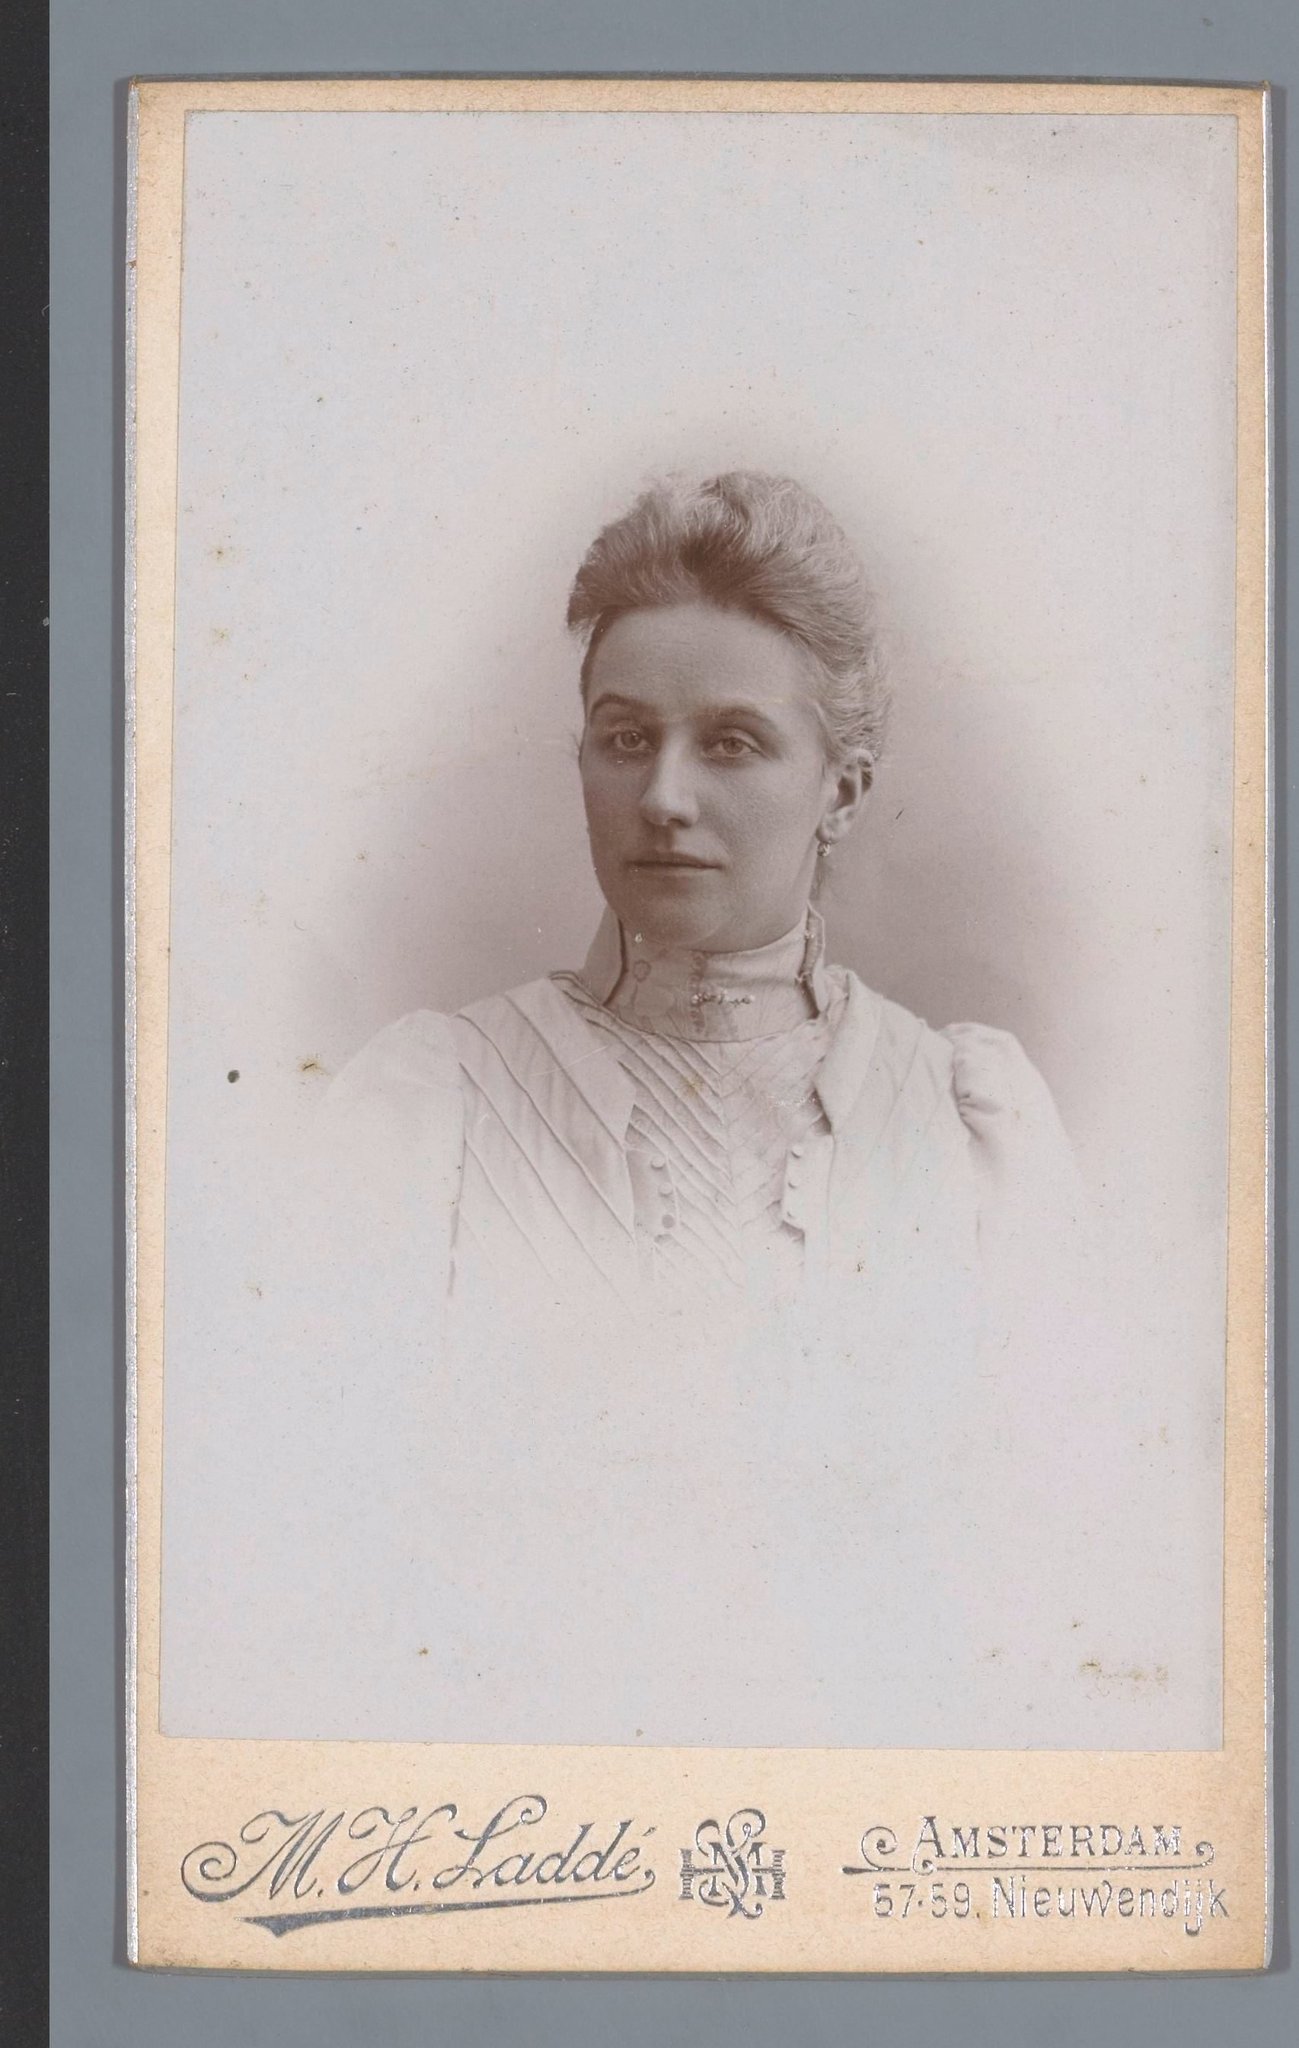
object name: photograph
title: Portret van een onbekende vrouw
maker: machiel hendricus laddé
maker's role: fotograaf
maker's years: 1866-1932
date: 1892-1906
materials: cardboard, paper, photographic support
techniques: collodion silver print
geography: amsterdam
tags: adult woman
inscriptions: name: ‘Photographie Artistique M.H. Laddé Boven de firma Merkelbach & Co. Amsterdam 57-59 Nieuwendijk Het Cliche wordt voor verdere bestellingen bewaard’, name: ‘M.H. Laddé Amsterdam 57-59. Nieuwendijk’, name: ‘B.P. Grimaud. Paris’